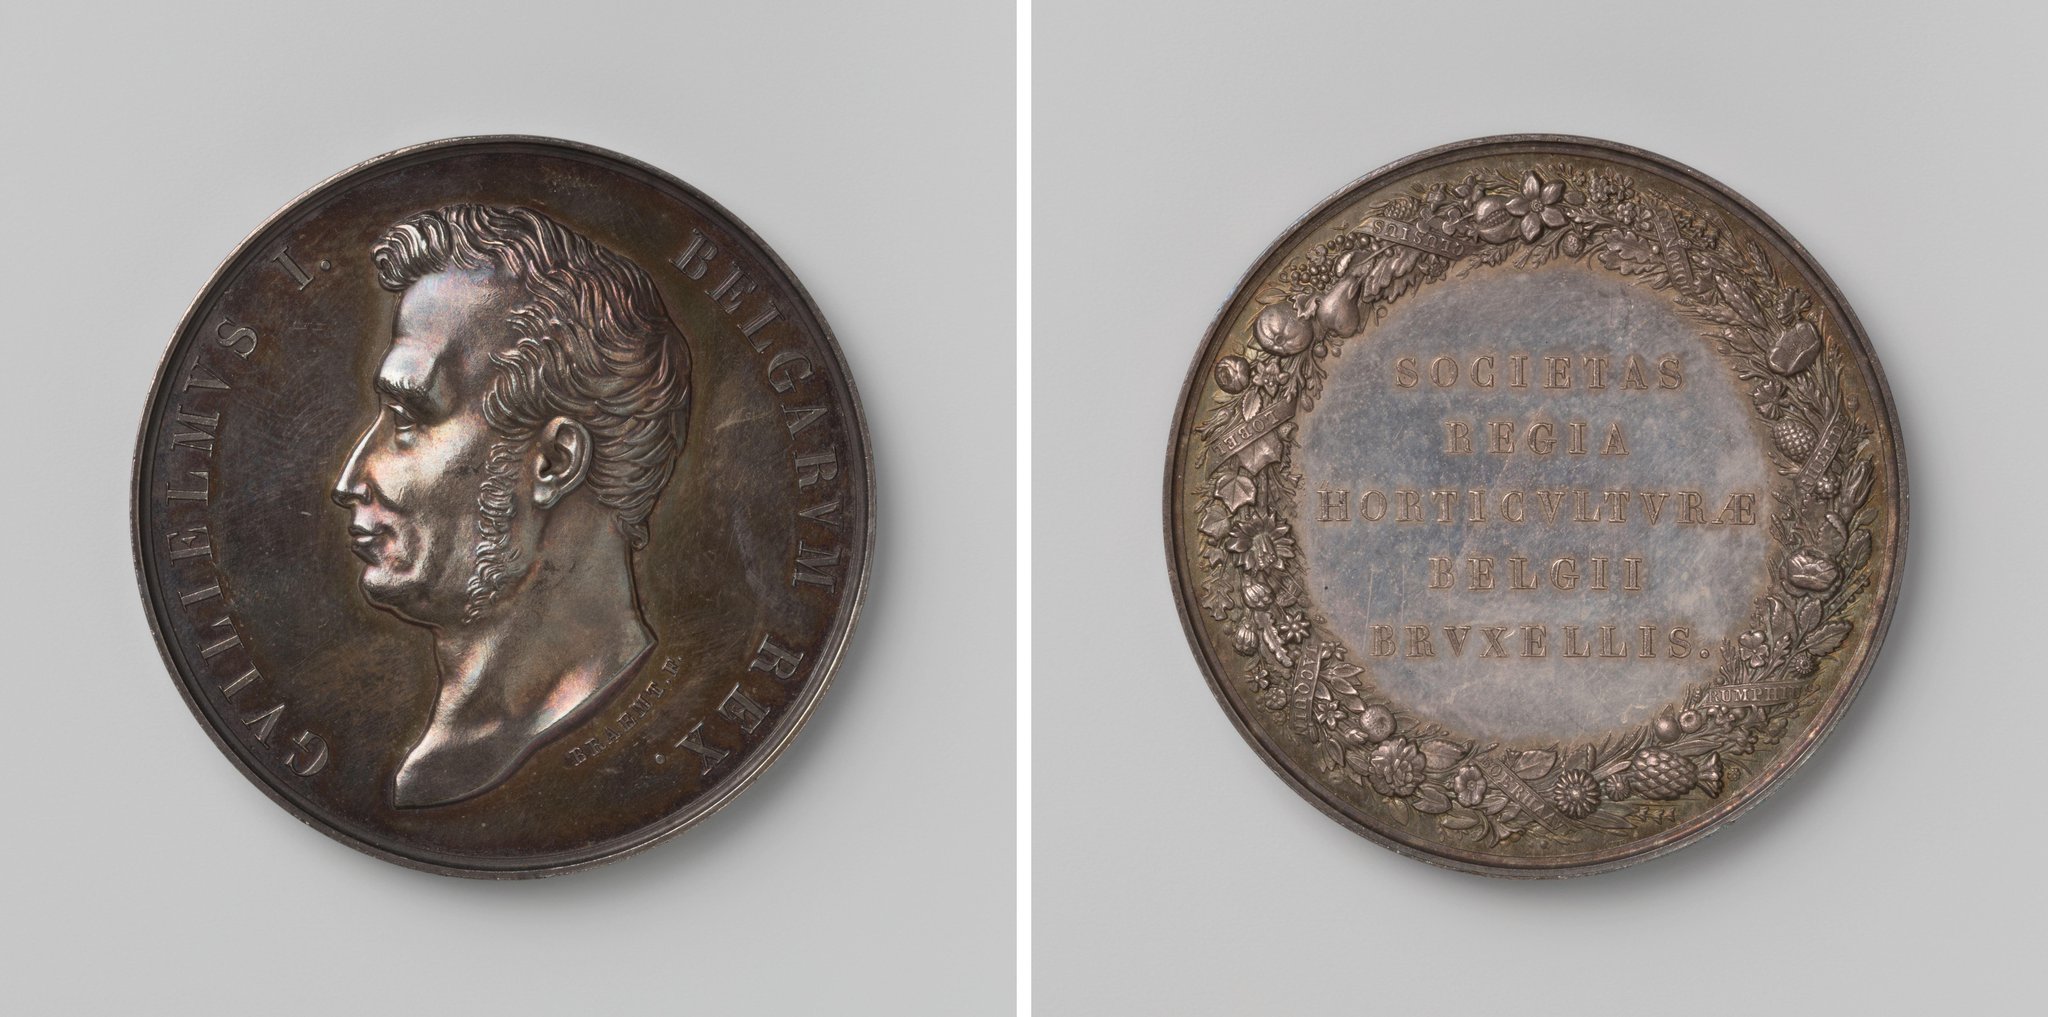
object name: medal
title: Koninklijke Maatschappij van Tuinbouw te Brussel, ter ere van Willem I Frederik, koning der Nederlanden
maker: joseph pierre braemt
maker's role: print maker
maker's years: 1796-1864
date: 1826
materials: silver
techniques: striking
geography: brussels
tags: the hague, berlin, william i of the netherlands, brussels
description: Zilveren penning. Voorzijde: borststuk man binnen omschrift. Keerzijde: opschrift binnen krans van bloemen en vruchten, omwonden met lint met opschrift